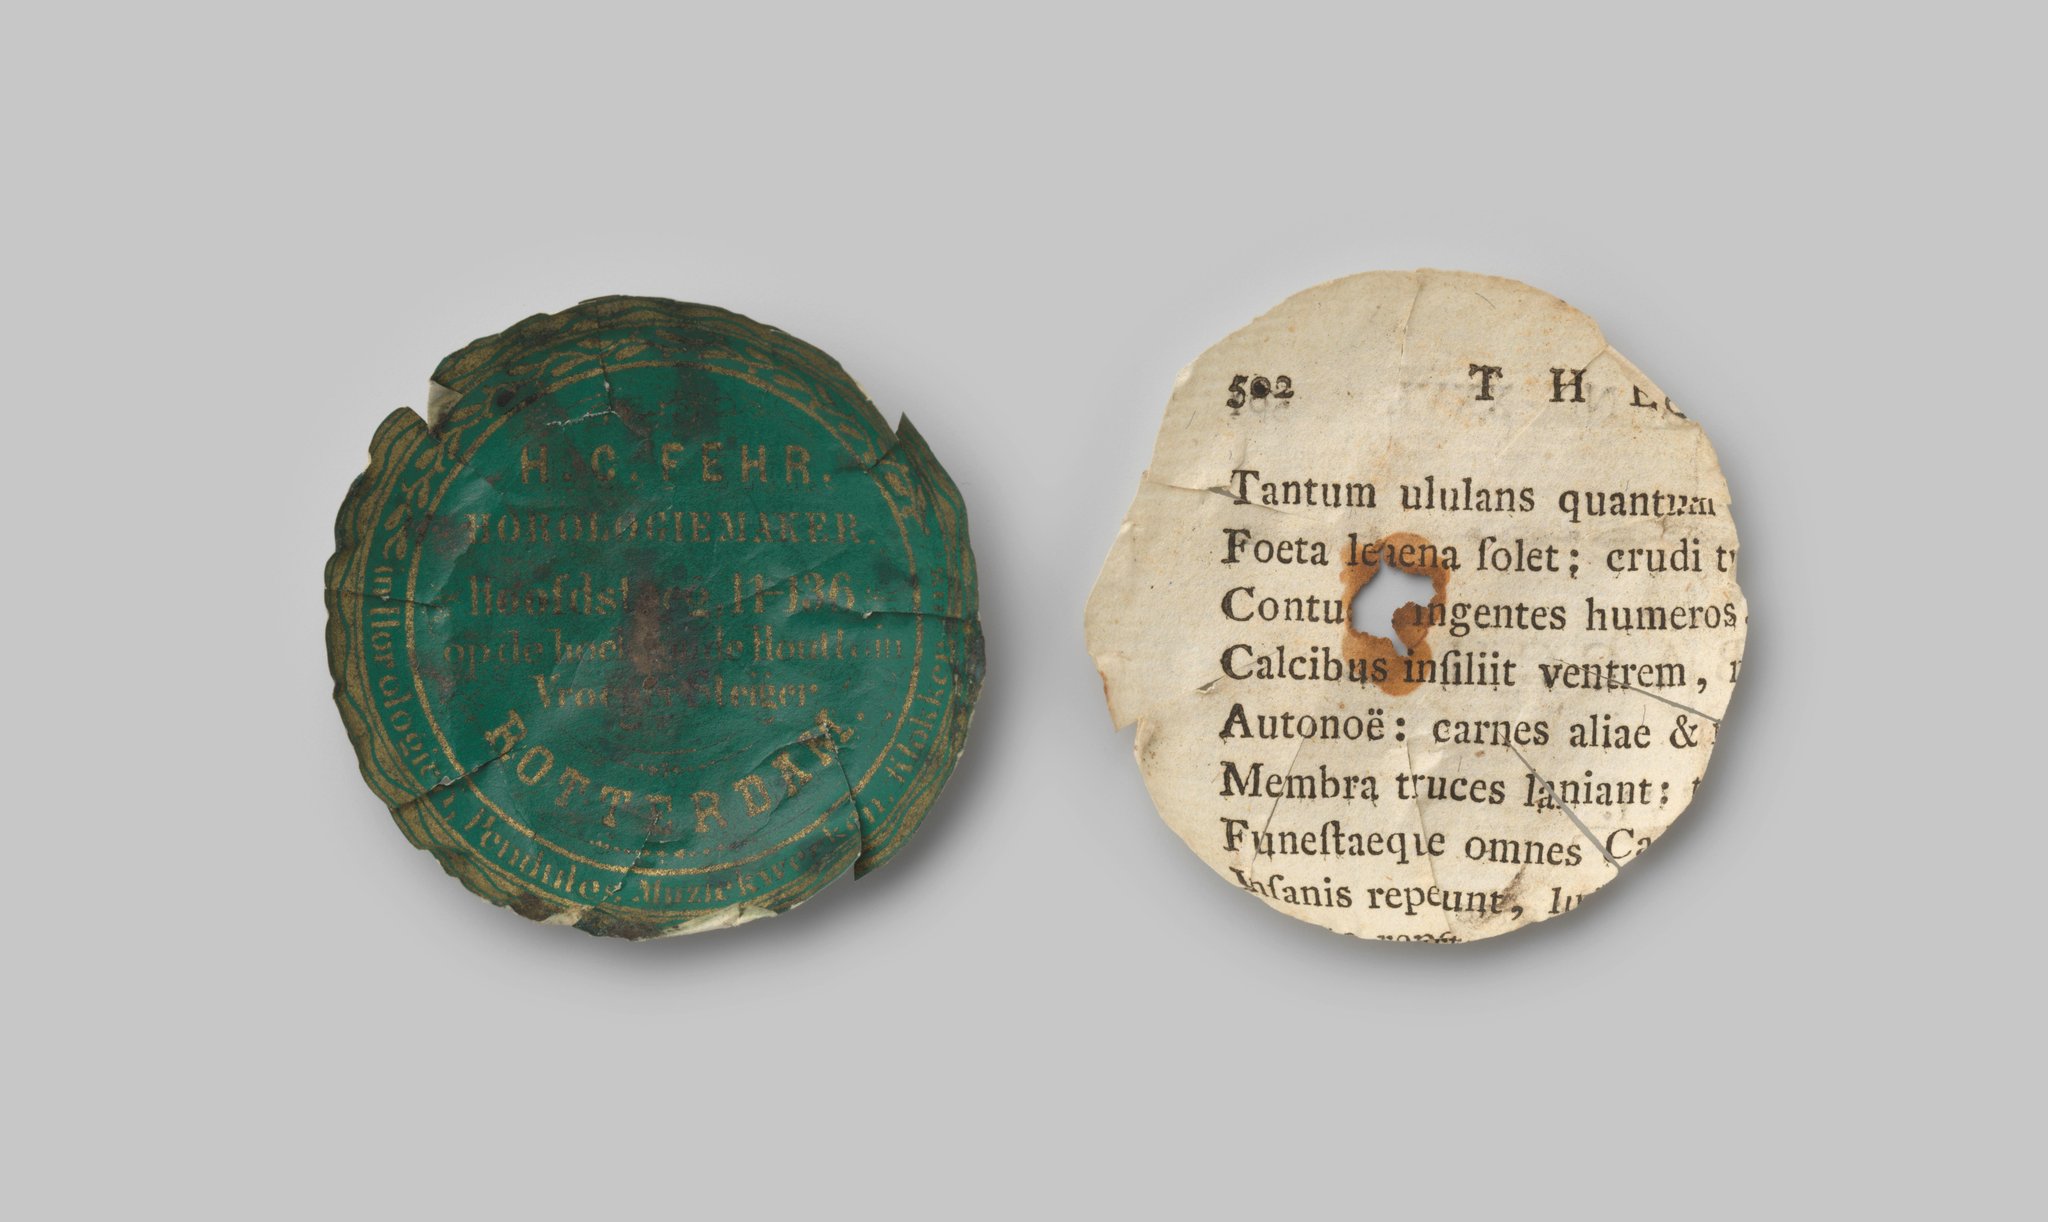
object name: document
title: Document behorend bij een horloge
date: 1750-1800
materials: paper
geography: rotterdam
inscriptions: mark: ‘PP boven ster in hart’, retailer's mark: ‘H.C. Fehr horlogemaker. Hoofdsteeg 11-136. Op de hoek van de houttuin, vroeger Steiger, Rotterdam in horlogien, pendules, muziekwerken, klokken.’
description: Groen papier, dat ingeplakt was in de kast: H.C. Fehr horlogemaker. Hoofdsteeg 11-136. Op de hoek van de houttuin, vroeger Steiger, Rotterdam in horlogien, pendules, muziekwerken, klokken.